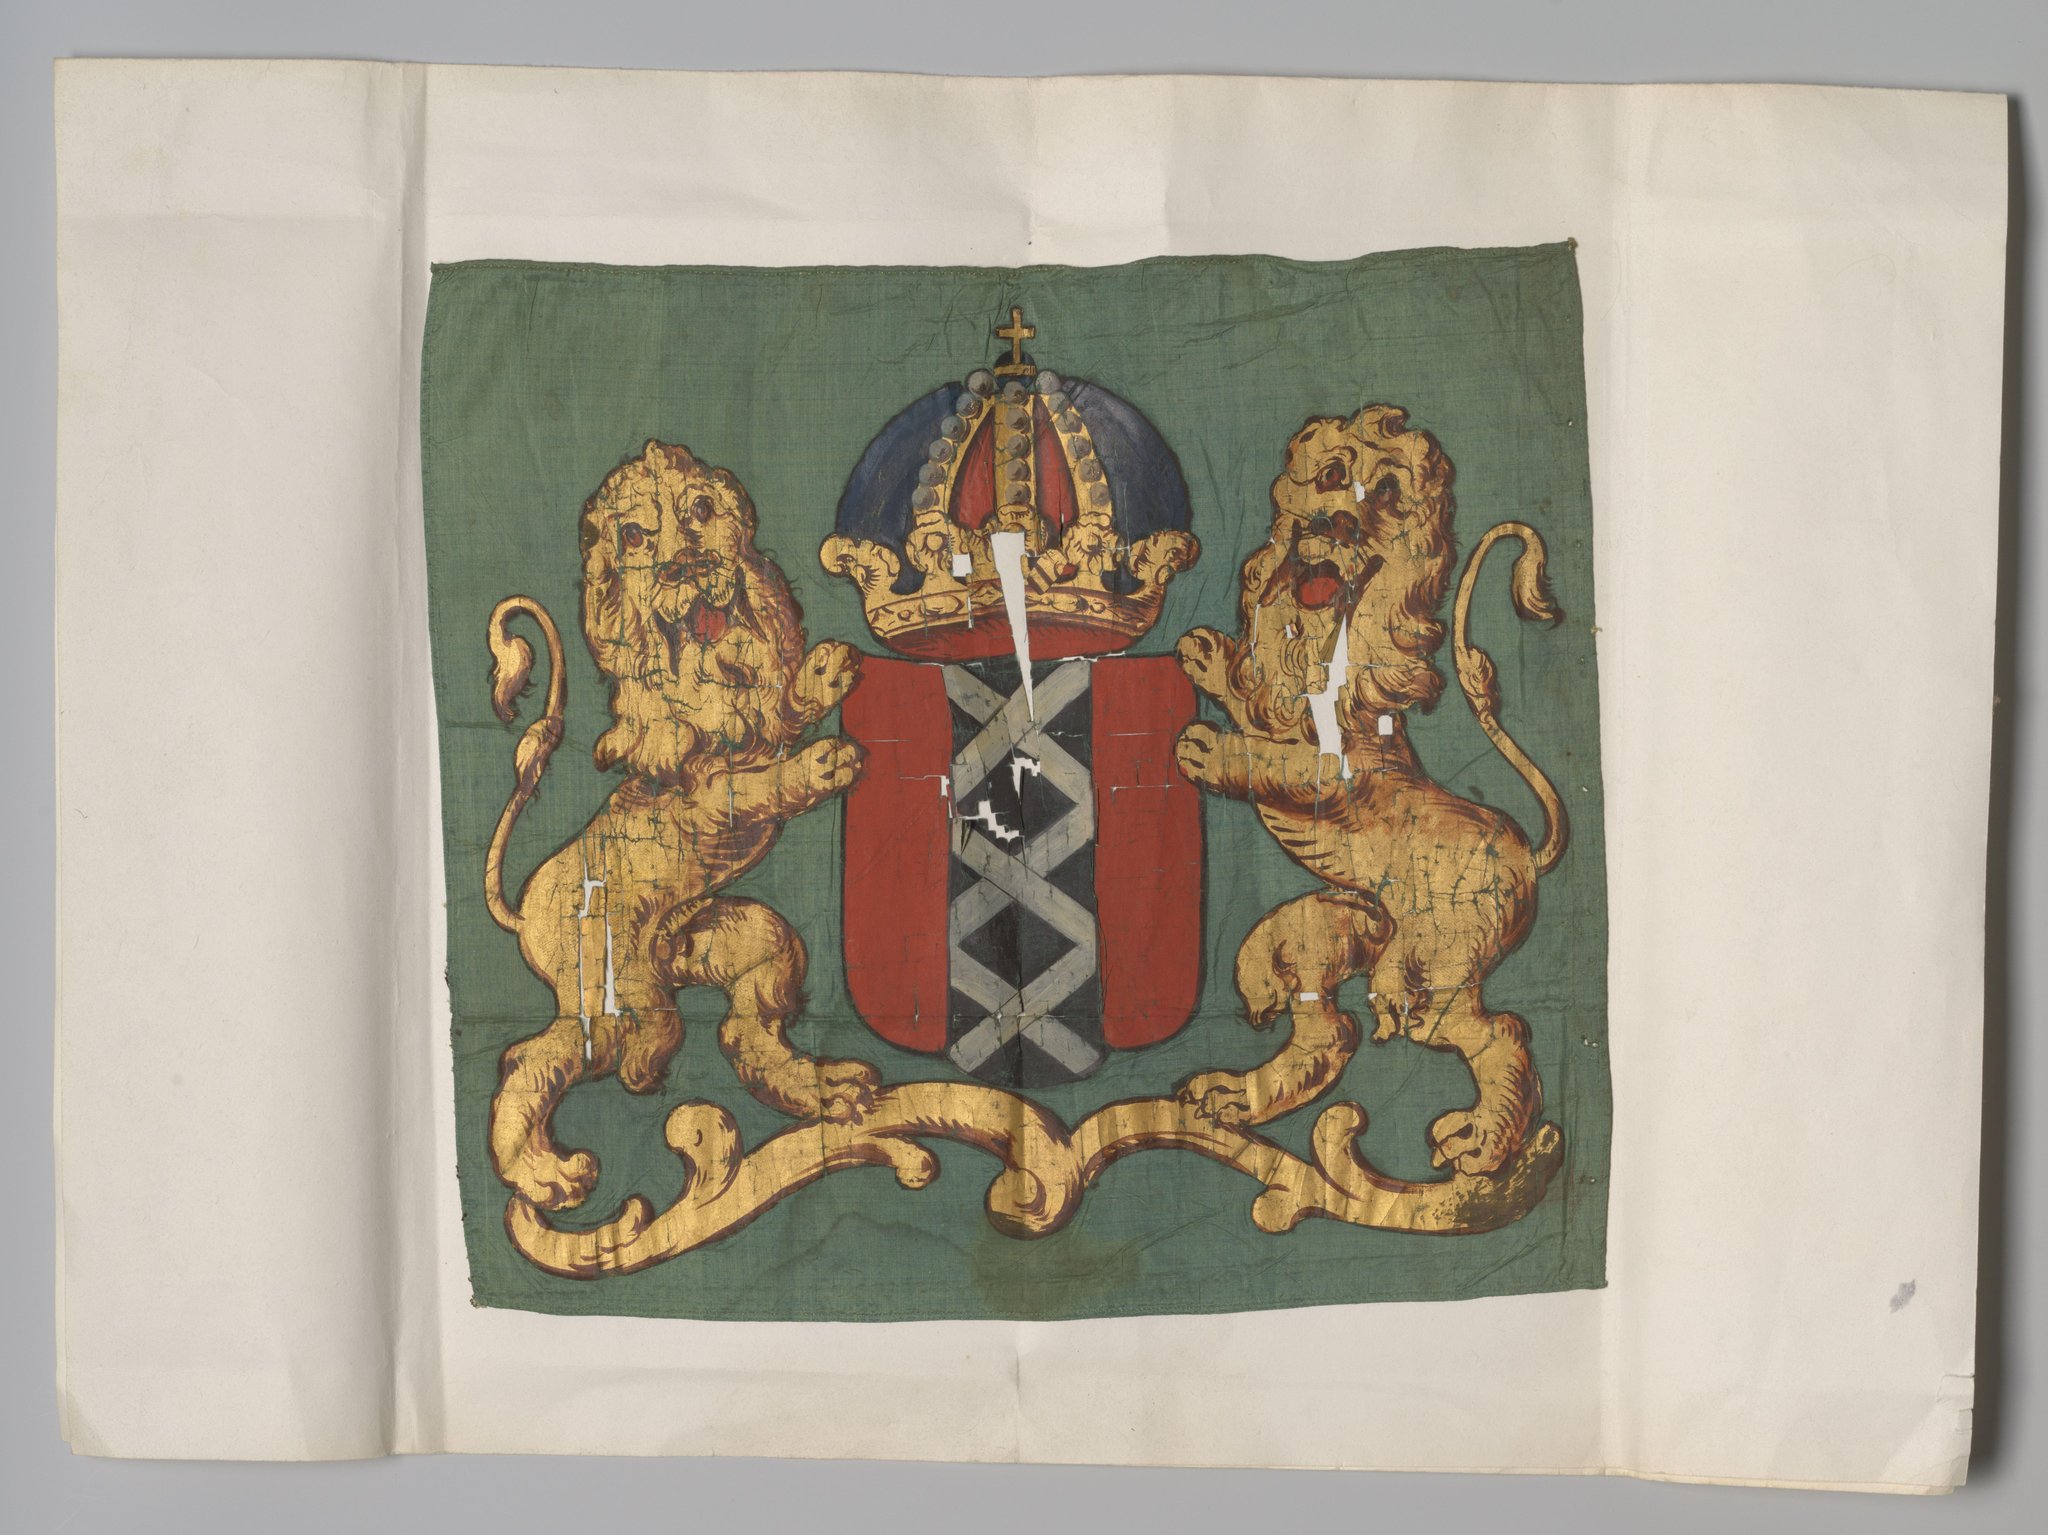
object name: banner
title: Wapen van Amsterdams schuttersvaandel van het groene regiment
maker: Anonymous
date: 1750-1795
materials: silk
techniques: painted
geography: netherlands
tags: coat of arms (as symbol of the state, etc.) (+ city; municipal), amsterdam